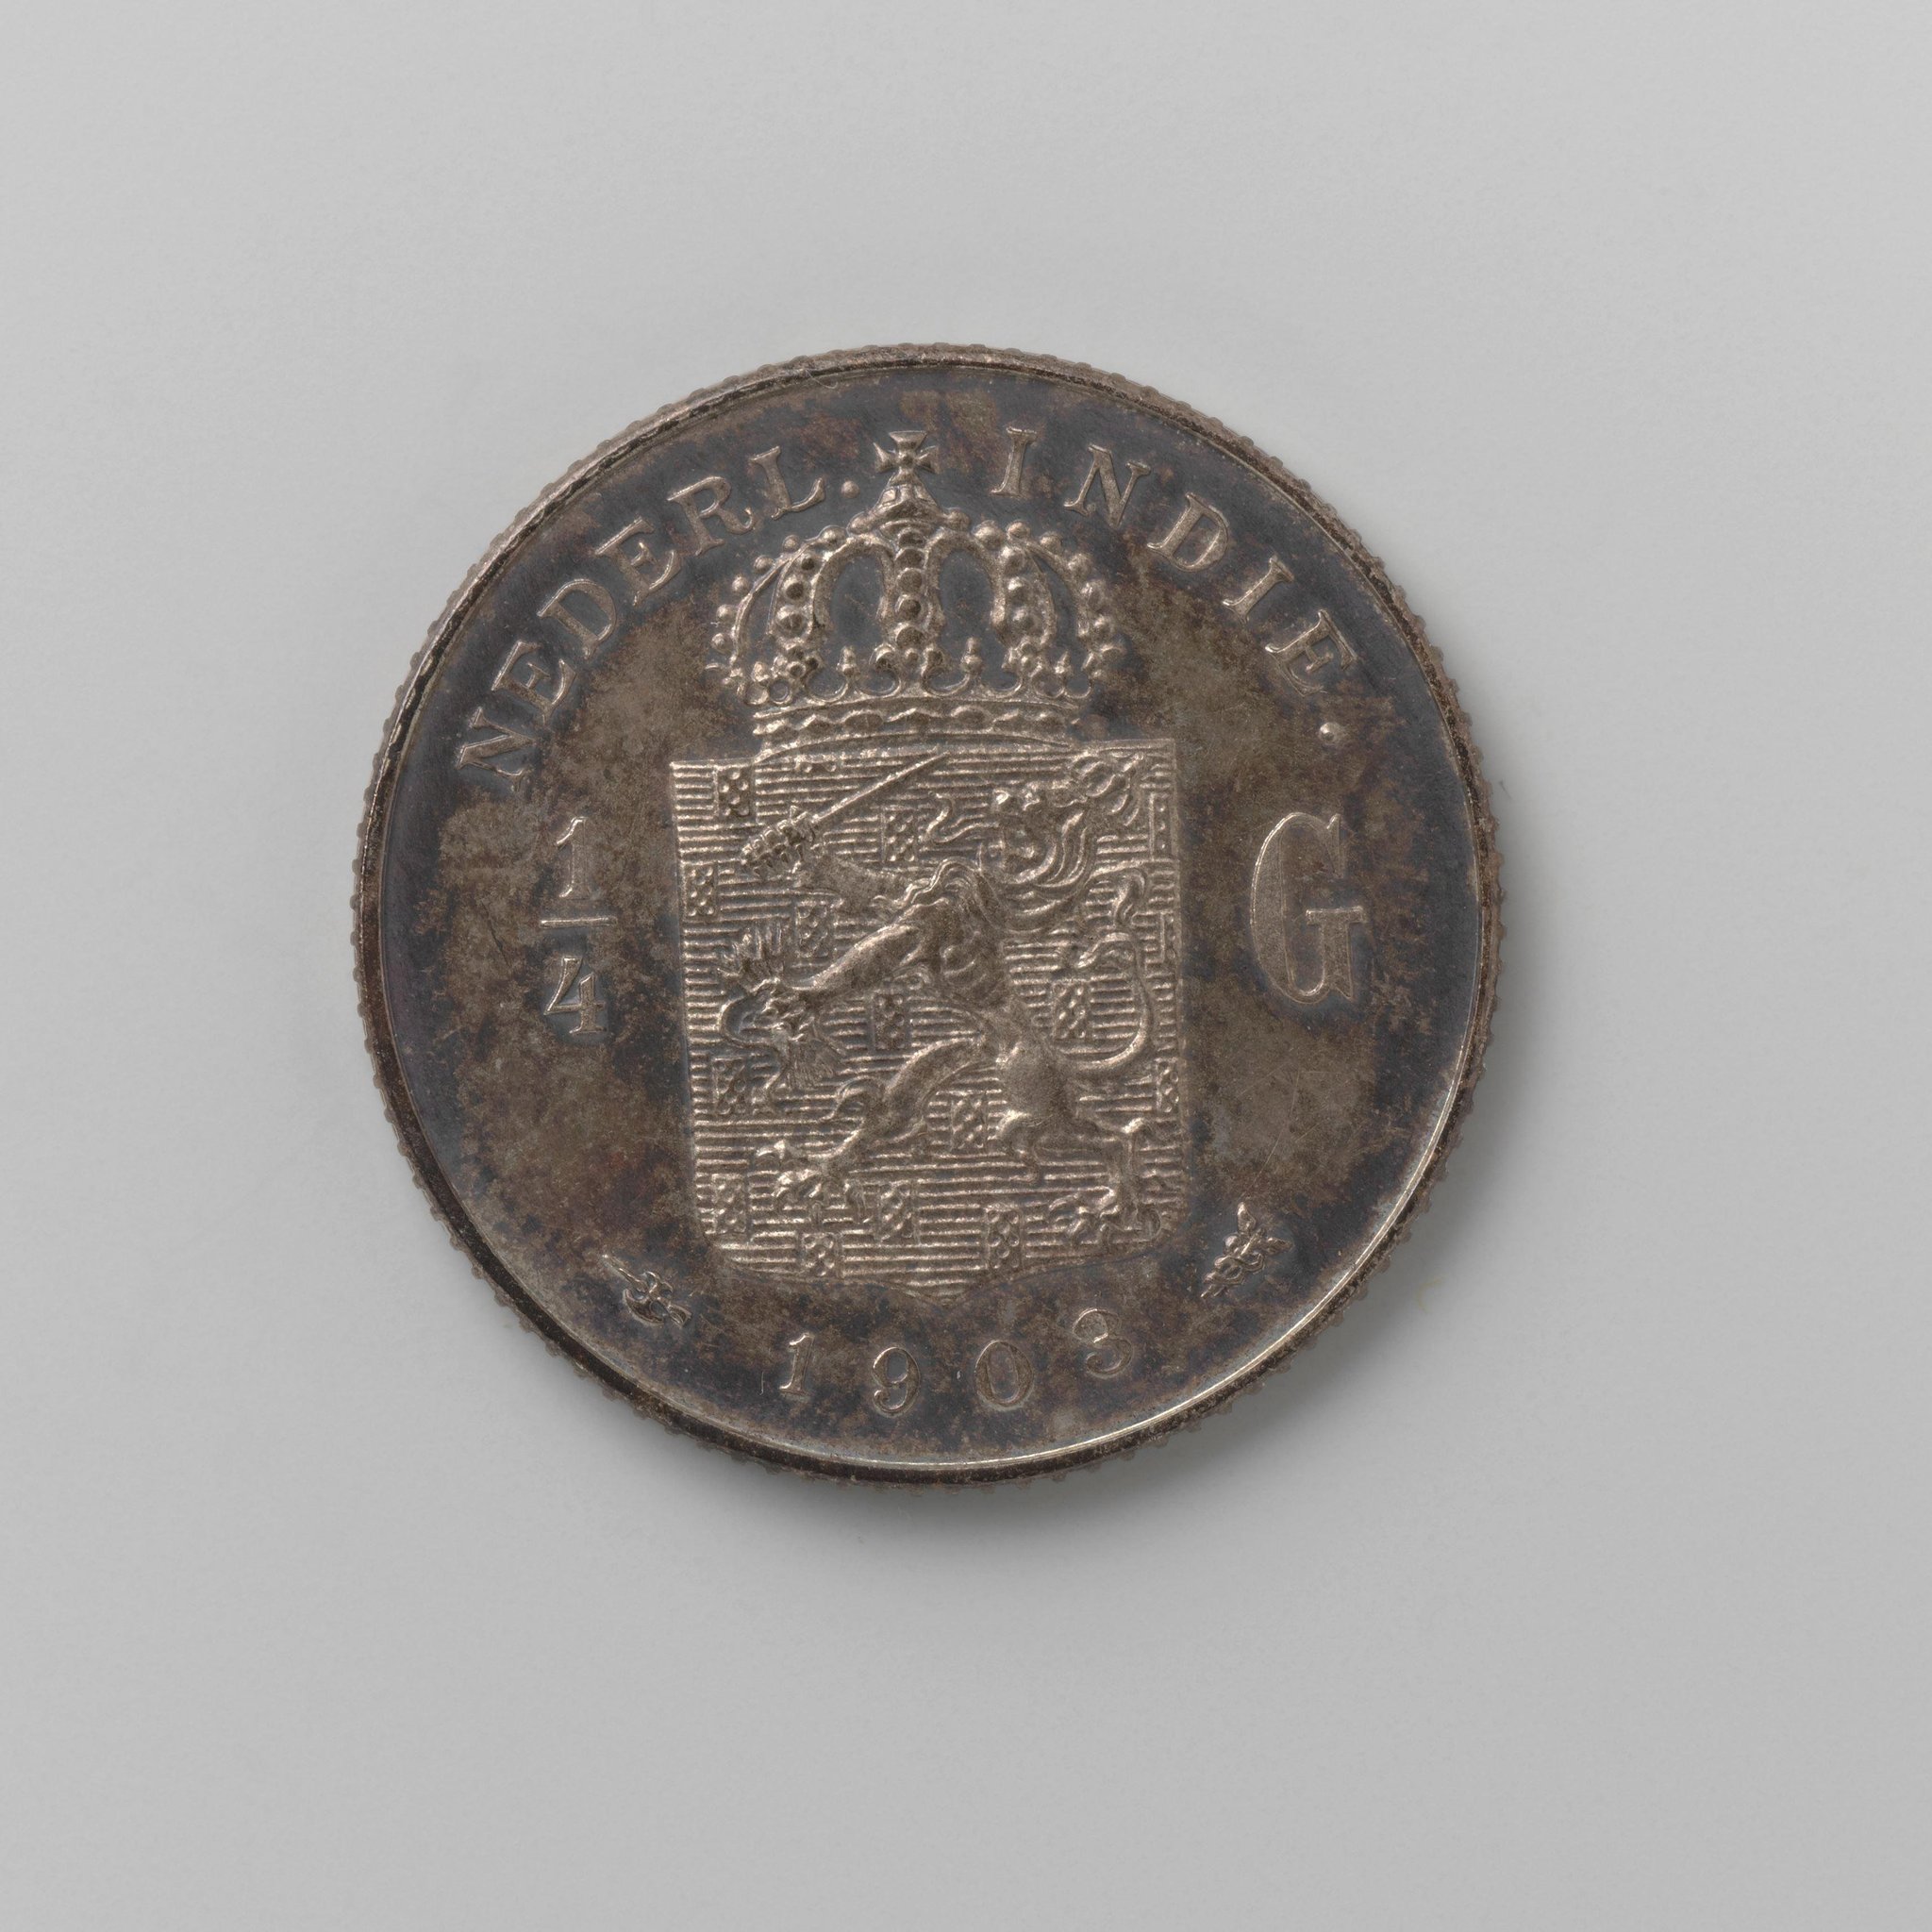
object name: coin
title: Nederlands Indië,1/4 gulden,1903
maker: wilhelmina of the netherlands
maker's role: print maker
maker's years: 1880-1962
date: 1903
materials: silver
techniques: striking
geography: utrecht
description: Zilveren munt. Voorzijde: tussen waarde-aanduiding 1/4 G gekroond rijkswapenschild. Boven kroon landsaanduiding en onder wapenschild jaartal. Keerzijde: drieregelig Maleis opschrift in Arabische tekens, waaromheen tussen zeven uitschietende stralen omschrift in het Javaans. Kartelrand.